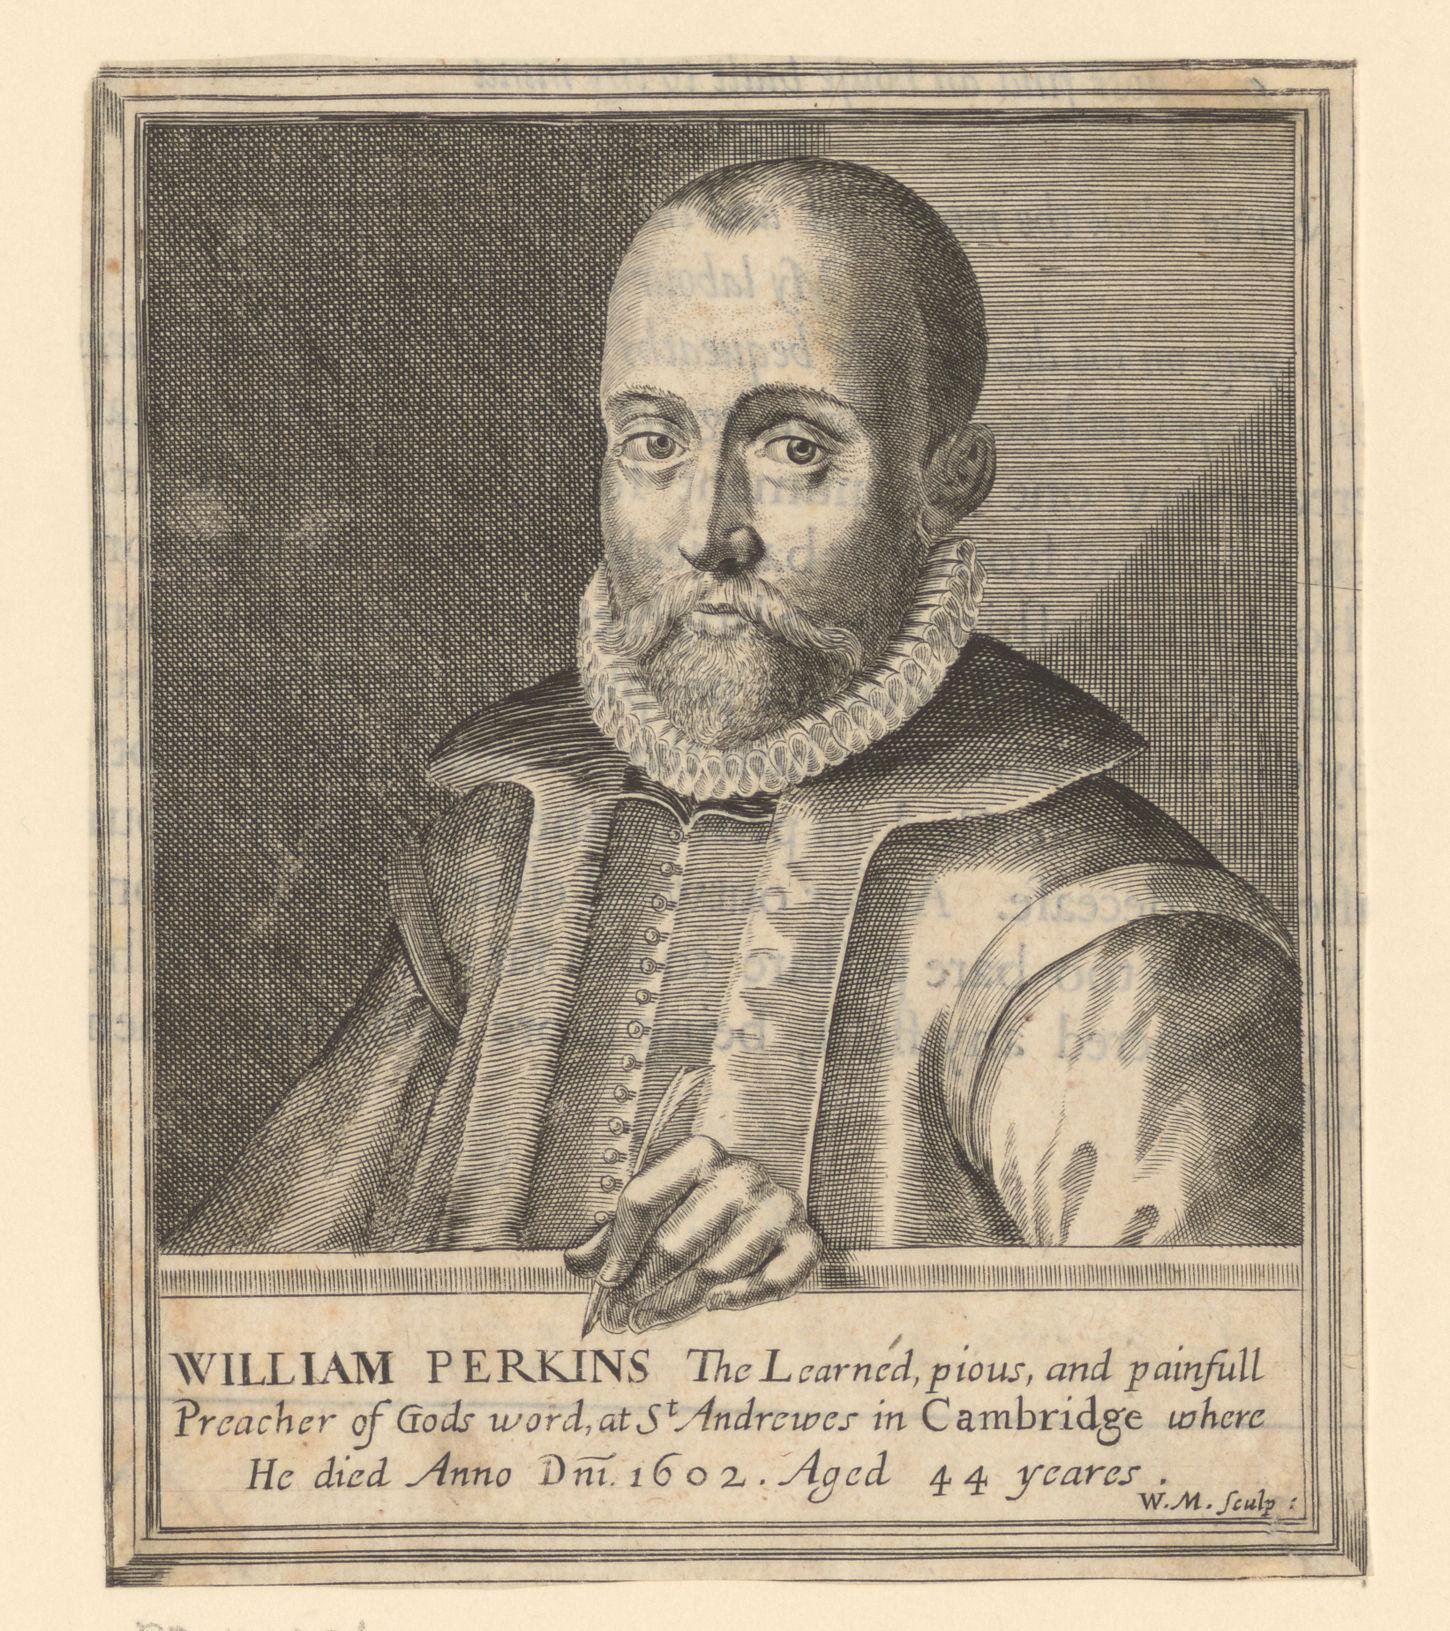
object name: print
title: Portret van William Perkins op 44-jarige leeftijd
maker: william marshall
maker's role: print maker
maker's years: -1649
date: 1617-1648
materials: paper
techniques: engraving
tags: theologian, historical persons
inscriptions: collector's mark: Lugt 2228